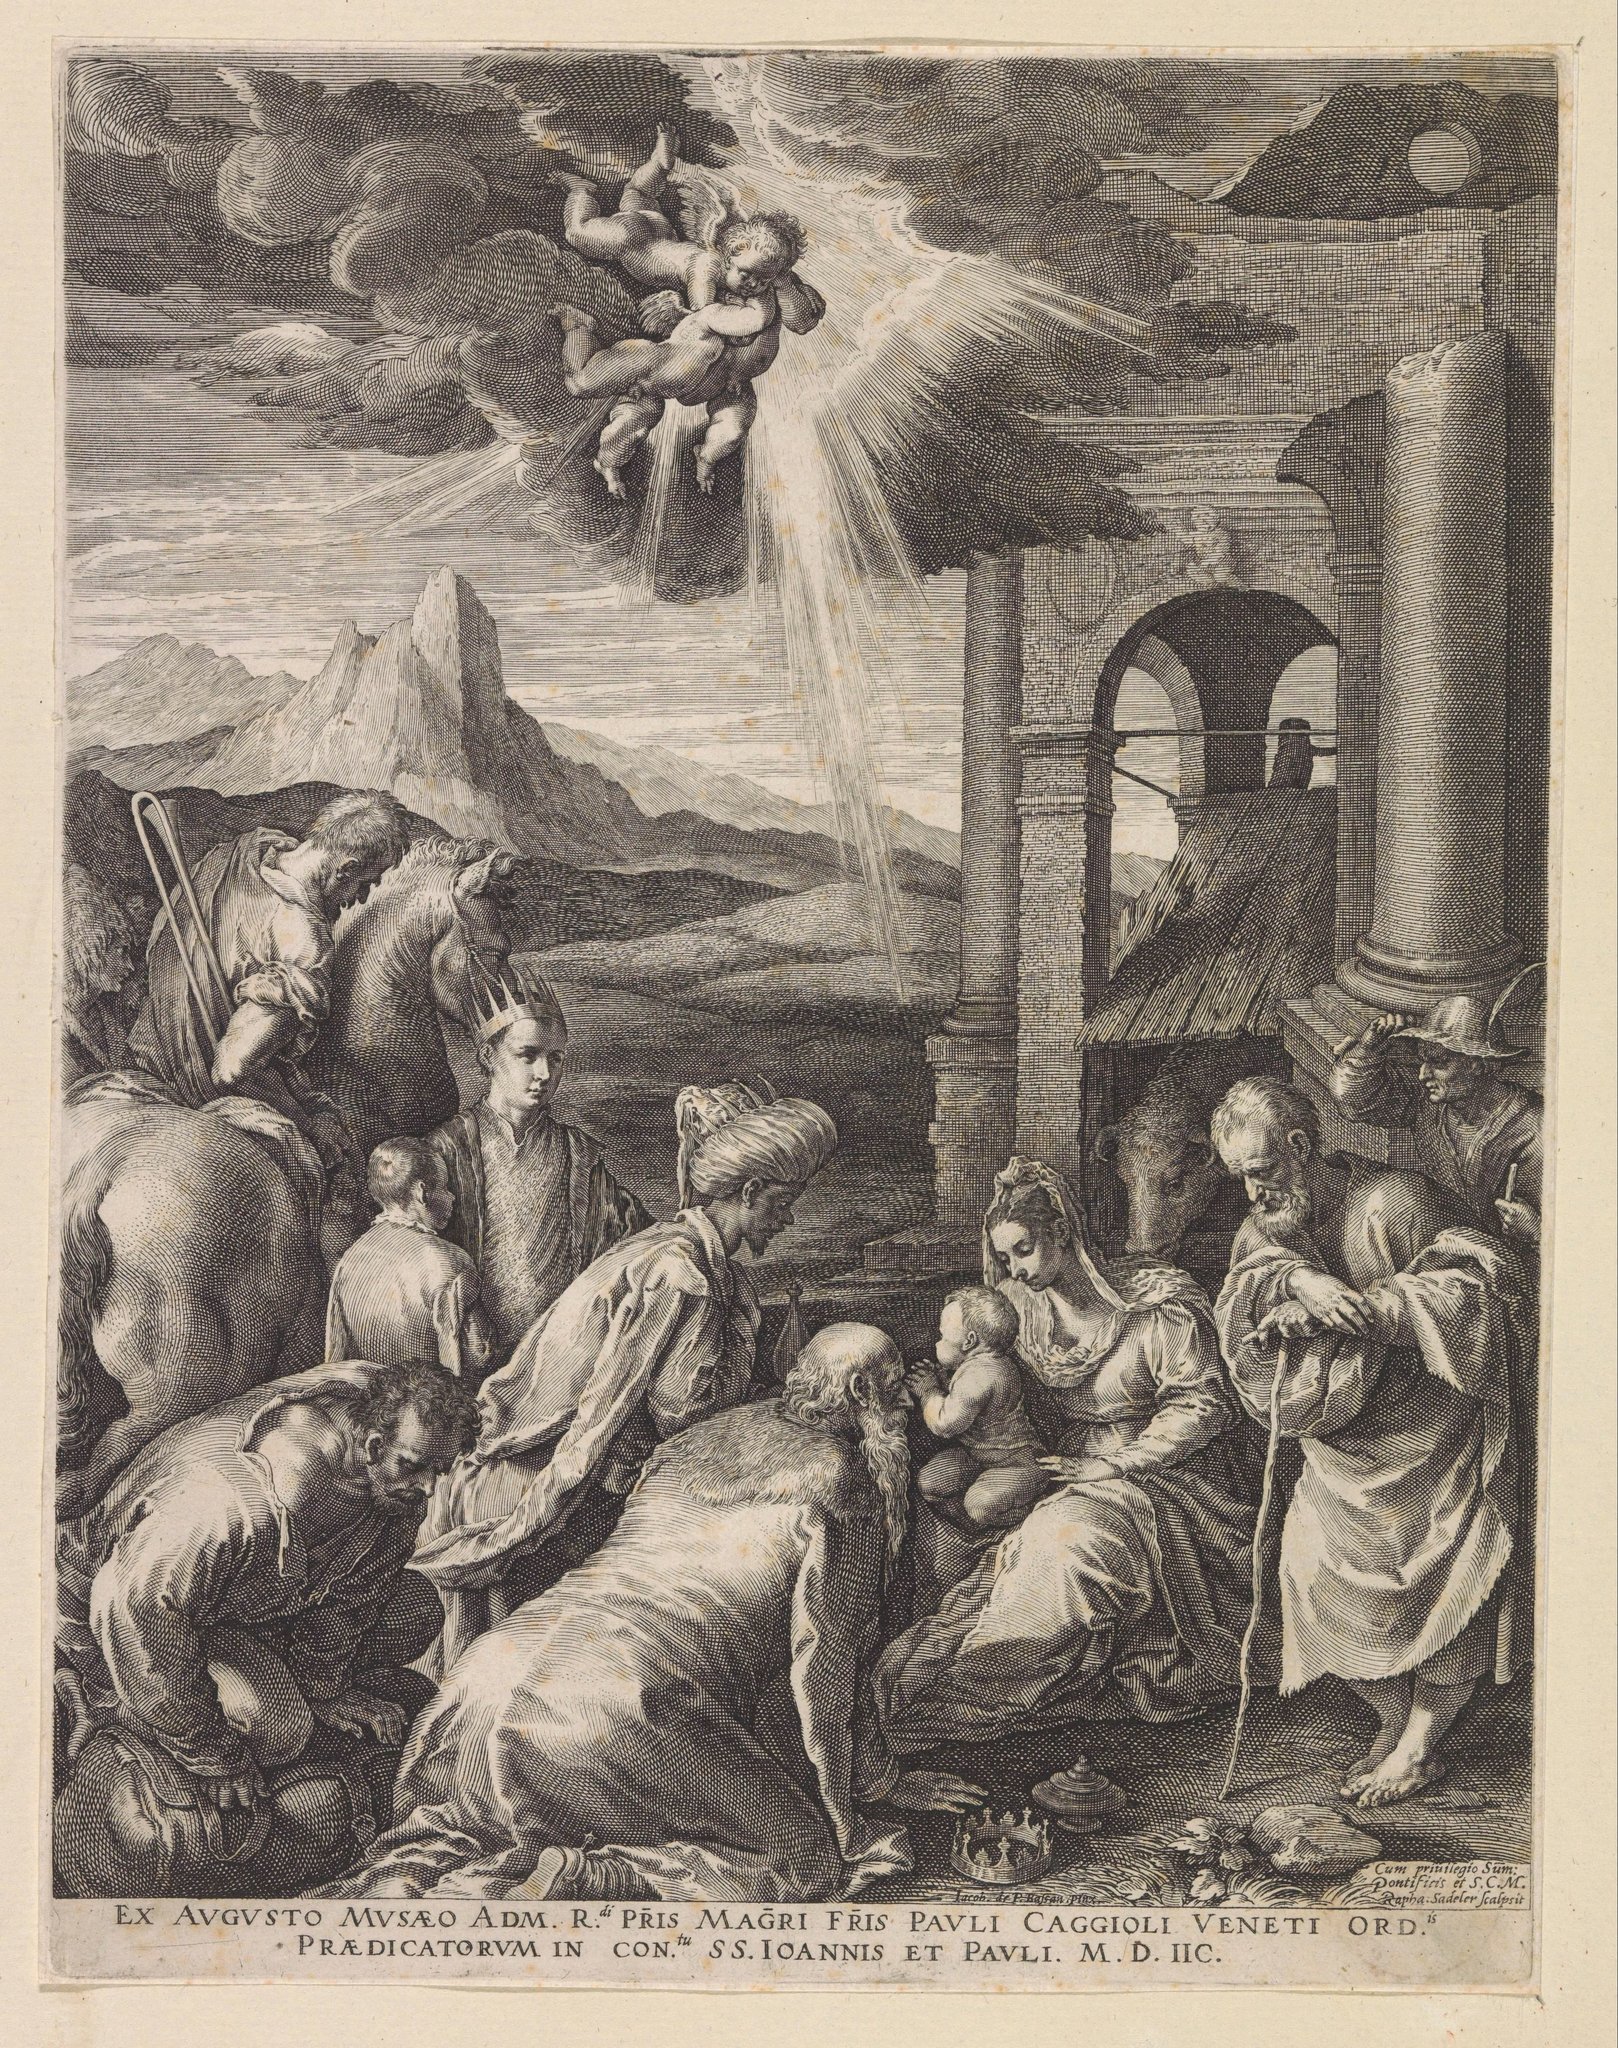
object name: print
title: Aanbidding der koningen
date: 1598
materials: paper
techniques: engraving, etching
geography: venice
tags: adoration of the kings: the wise men present their gifts to the christ-child (gold, frankincense and myrrh) (+ angel(s))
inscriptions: collector's mark: Lugt 240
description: Maria en Jozef tonen het Christuskind aan de drie koningen. De drie knielen en bieden het kind hun geschenken aan. In de lucht vliegen twee engelen.